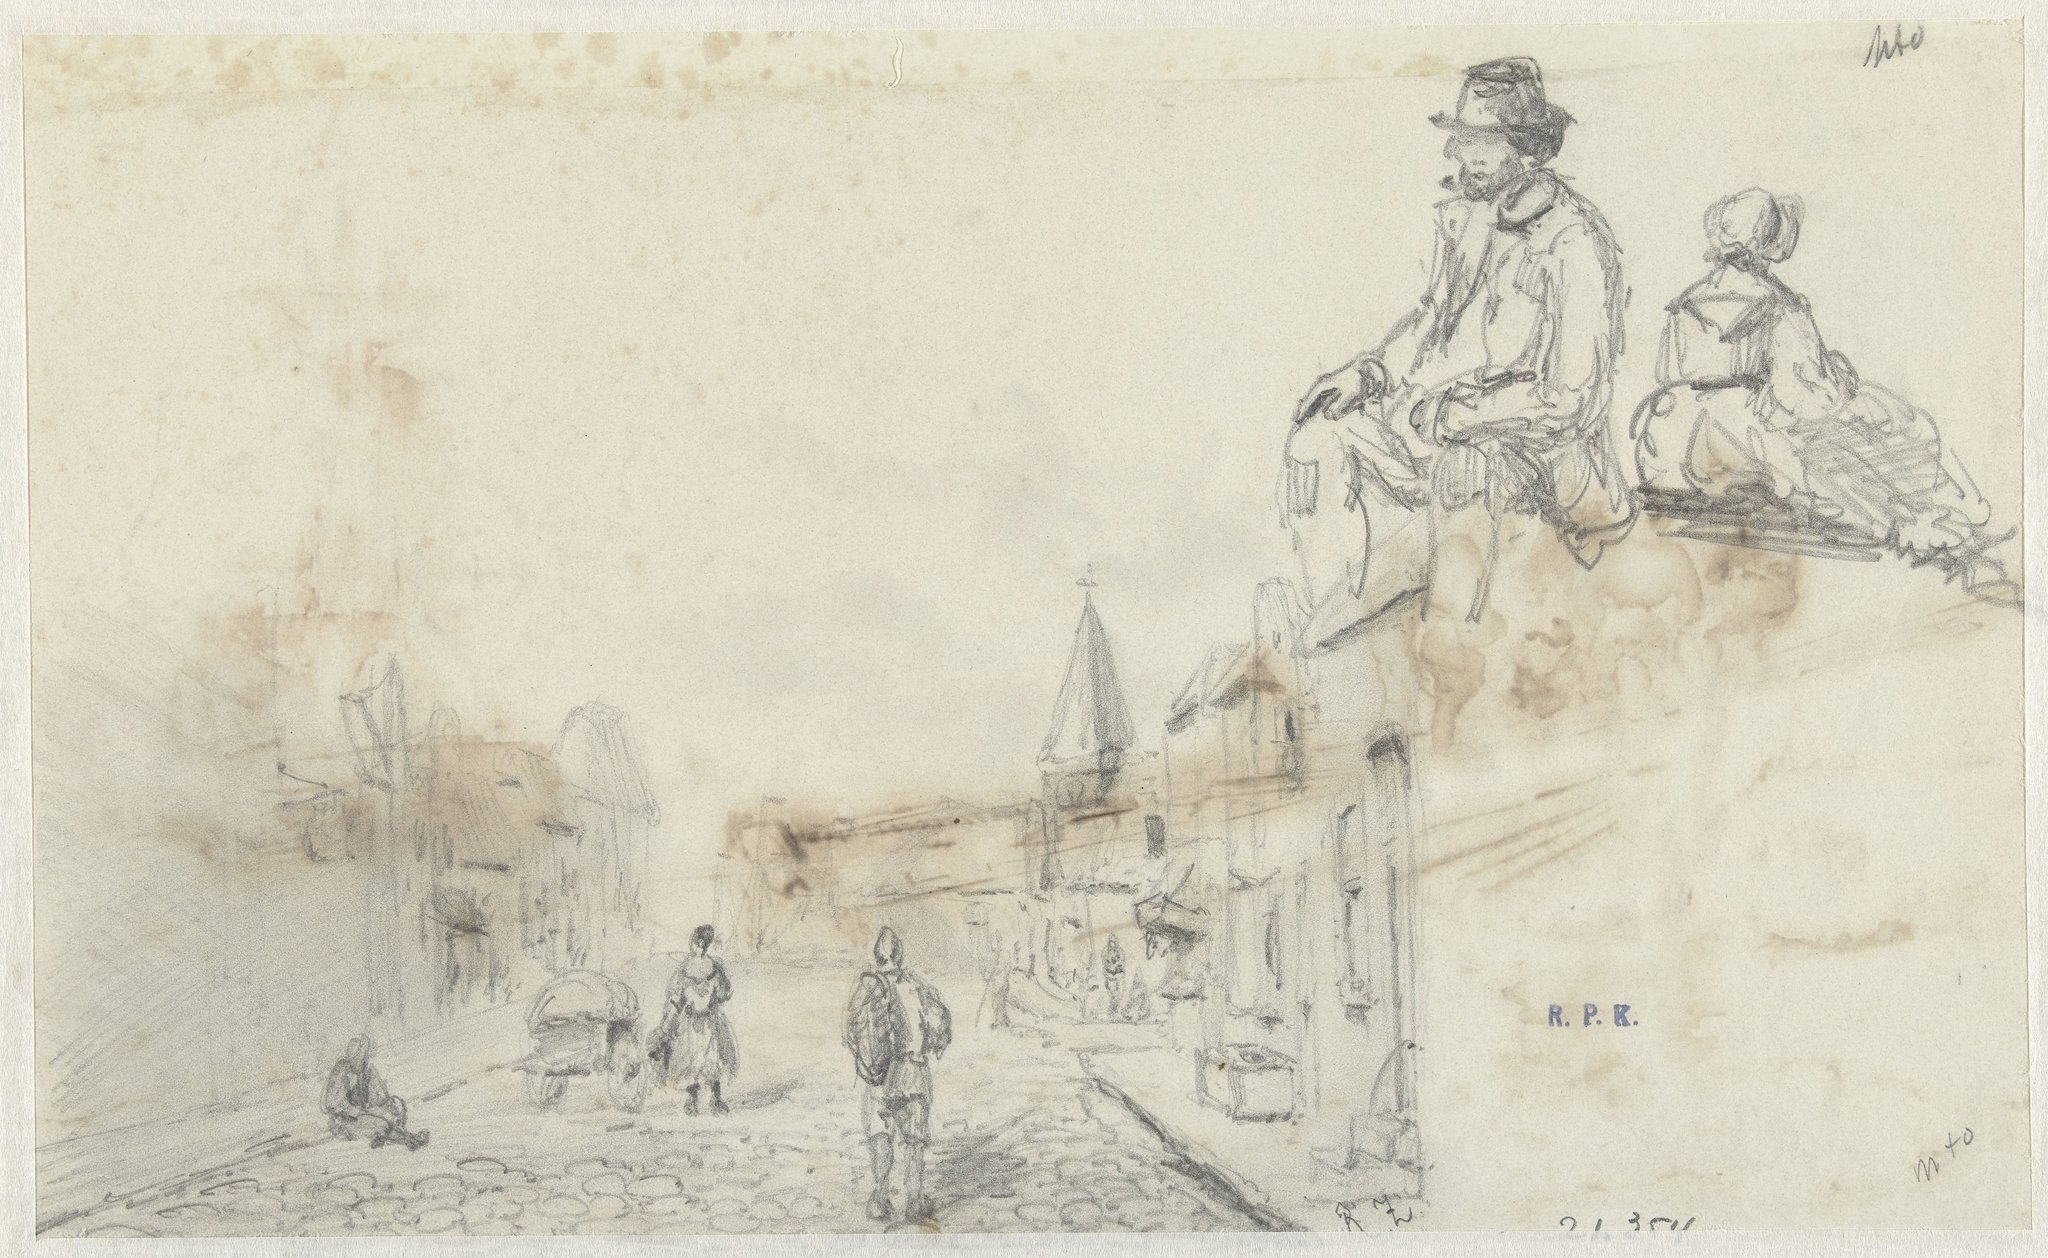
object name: drawing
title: Schetsen van een straat en twee zittende personen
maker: frans arnold breuhaus de groot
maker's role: draughtsman, print maker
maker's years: 1824-1872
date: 1834-1872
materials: paper, pencil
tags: street